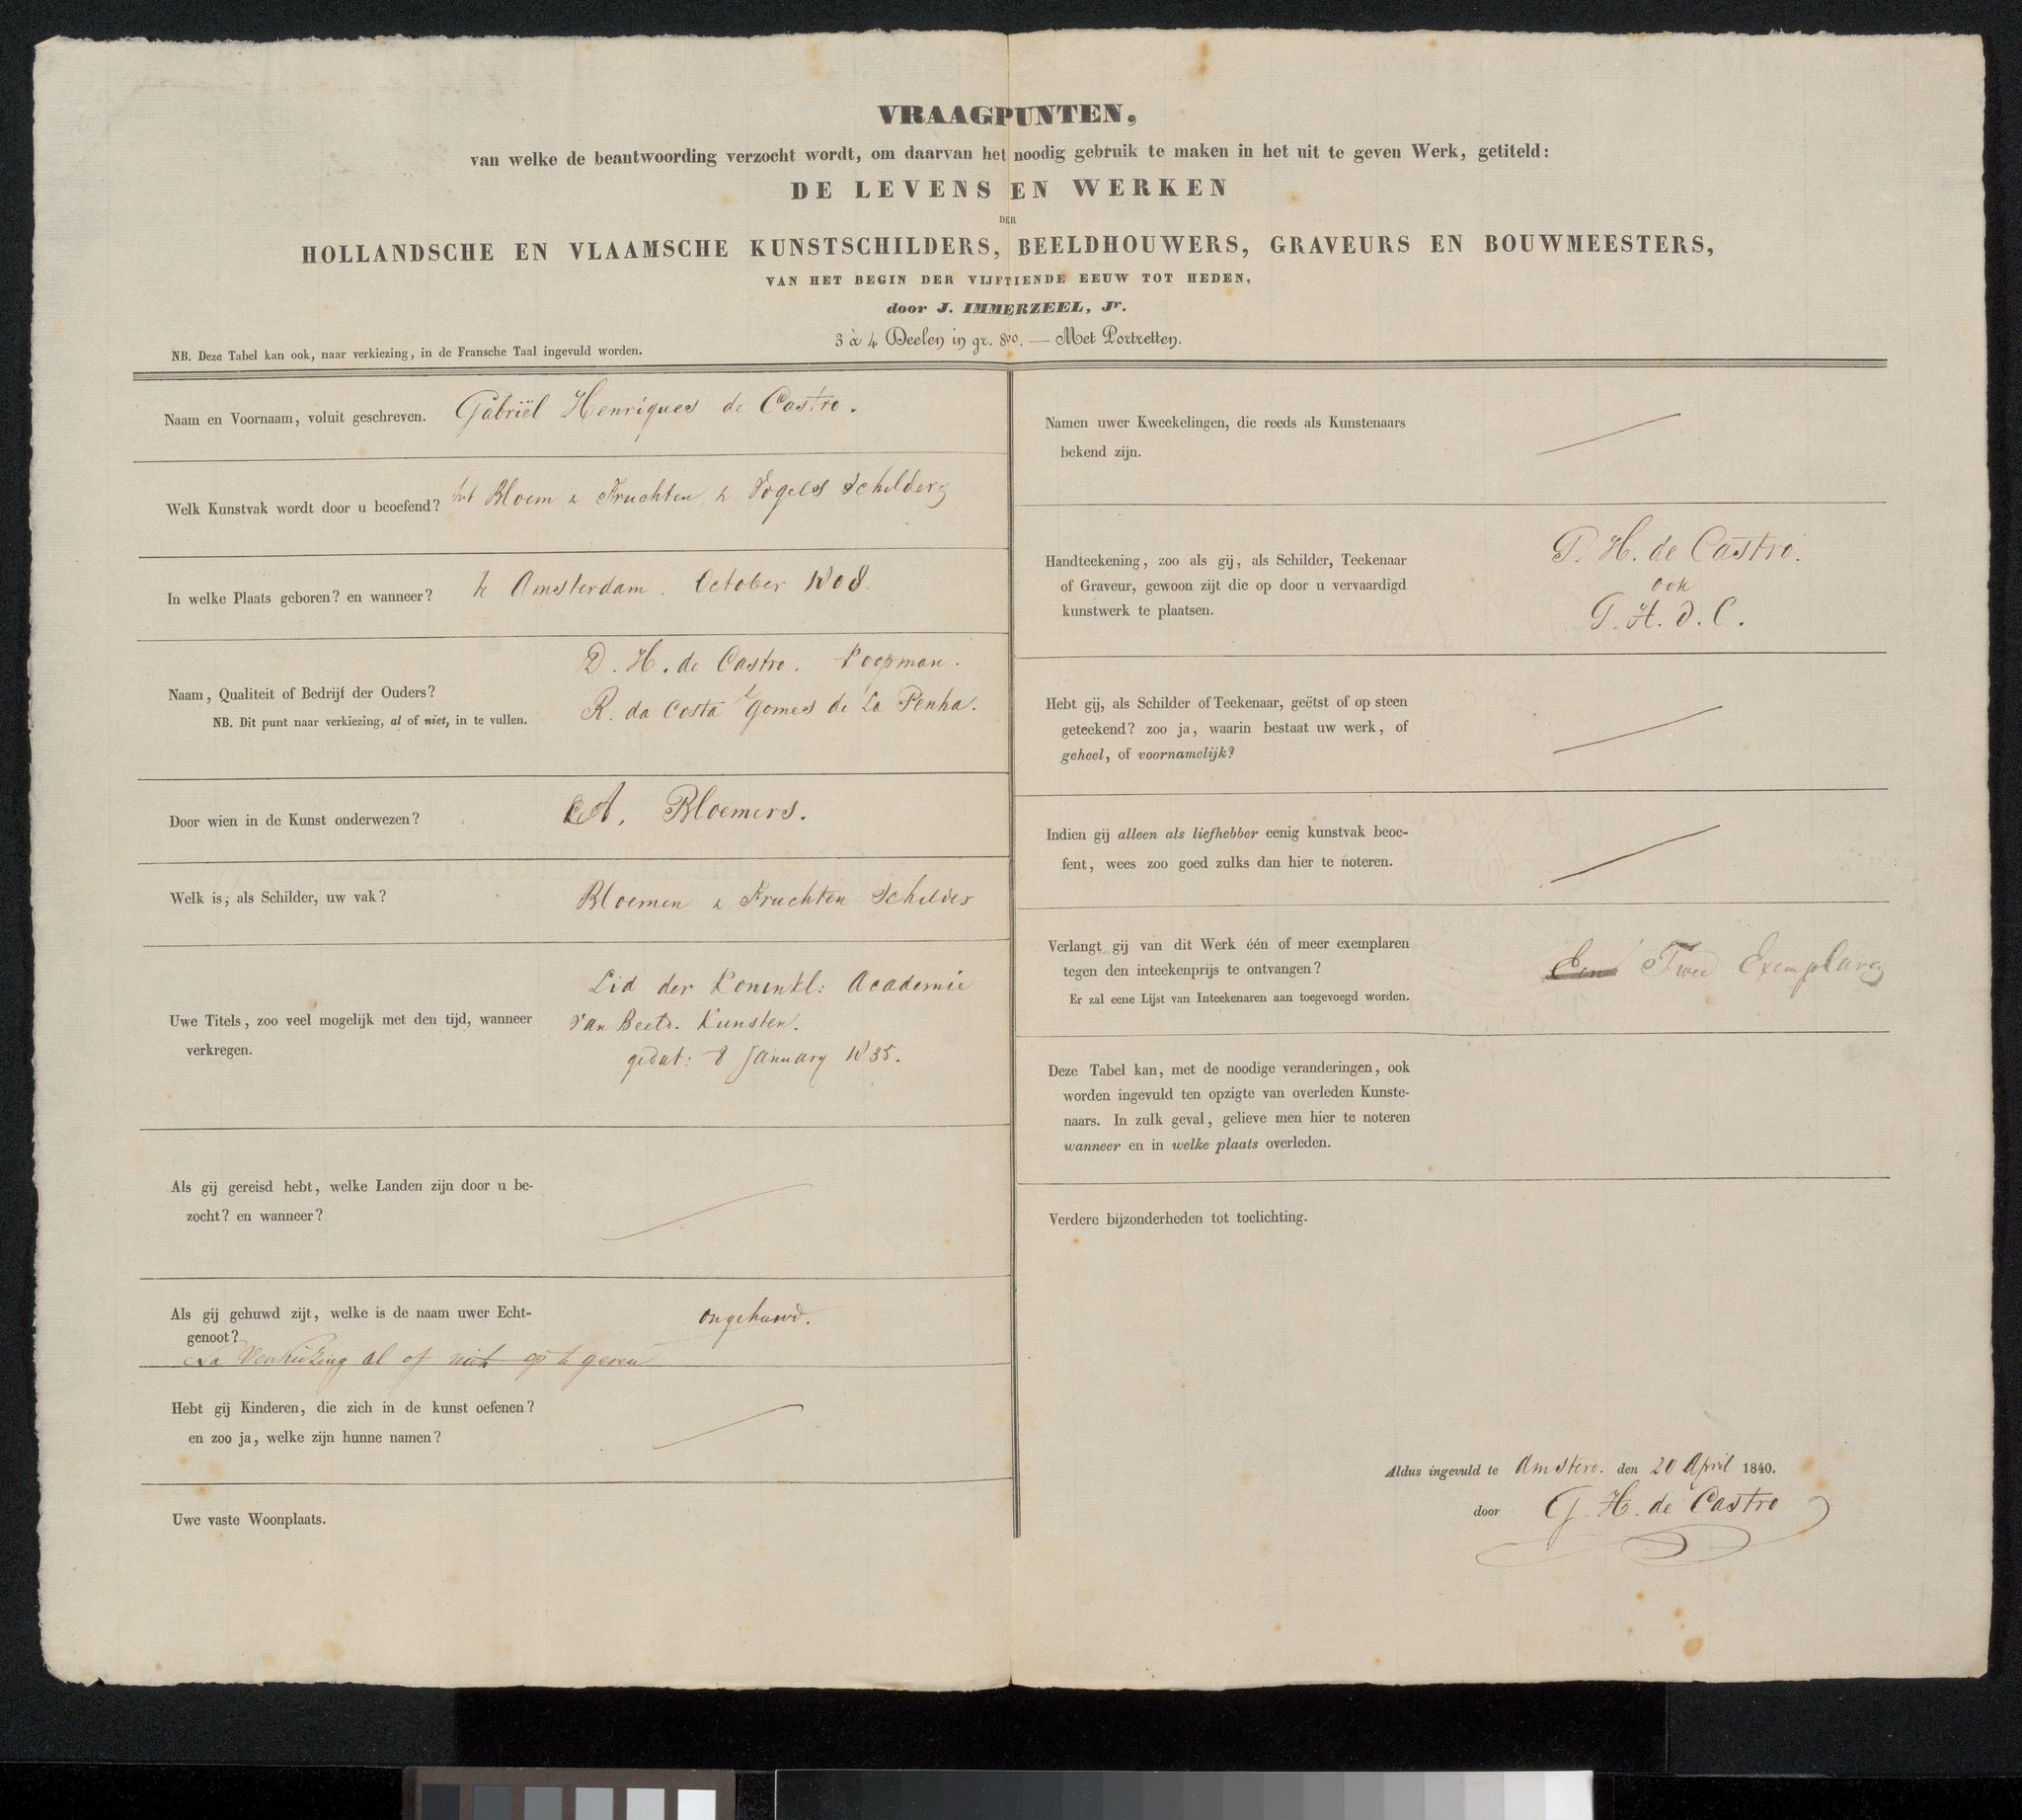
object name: questionnaire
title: Enquêteformulier ingevuld door Gabriël Henriques de Castro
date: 1840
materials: ink, paper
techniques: pen, printing, writing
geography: amsterdam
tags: painter, gabriël henriques de castro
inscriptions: watermark, inscription: ‘Vraagpunten,/ van welke de beantwoording verzocht wordt, om daarvan het noodig gebruik te maken in het uit te geven Werk, getiteld: De levens en werken/ der Hollandsche en Vlaamsche kunstschilders, beeldhouwers,/ graveurs en bouwmeesters, van het begin der vijftiende eeuw tot heden/ door J. Immerzeel, Jr.’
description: Opgenomen in: Immerzeel, J. Jr., De levens en werken der Hollandsche en Vlaamsche kunstschilders, beeldhouwers, graveurs en bouwmeesters, van het begin der vijftiende eeuw tot heden, Amsterdam: J.C. van Kesteren, 1842-1843.